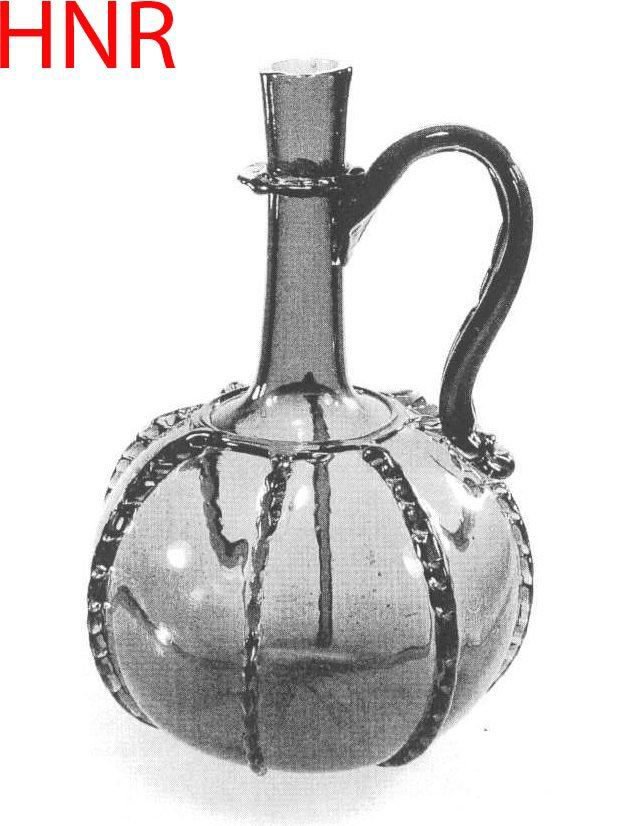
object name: carafe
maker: Anonymous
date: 1650-1710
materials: glass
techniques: glassblowing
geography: low countries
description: Licht ingestoken bodem. Bol lichaam met acht gekartelde ribben, aan de bovenzijde verbonden door een glad bandje. Slanke, rechte hals met een geknepen glasdraad rond de nek. S-vormig oor.